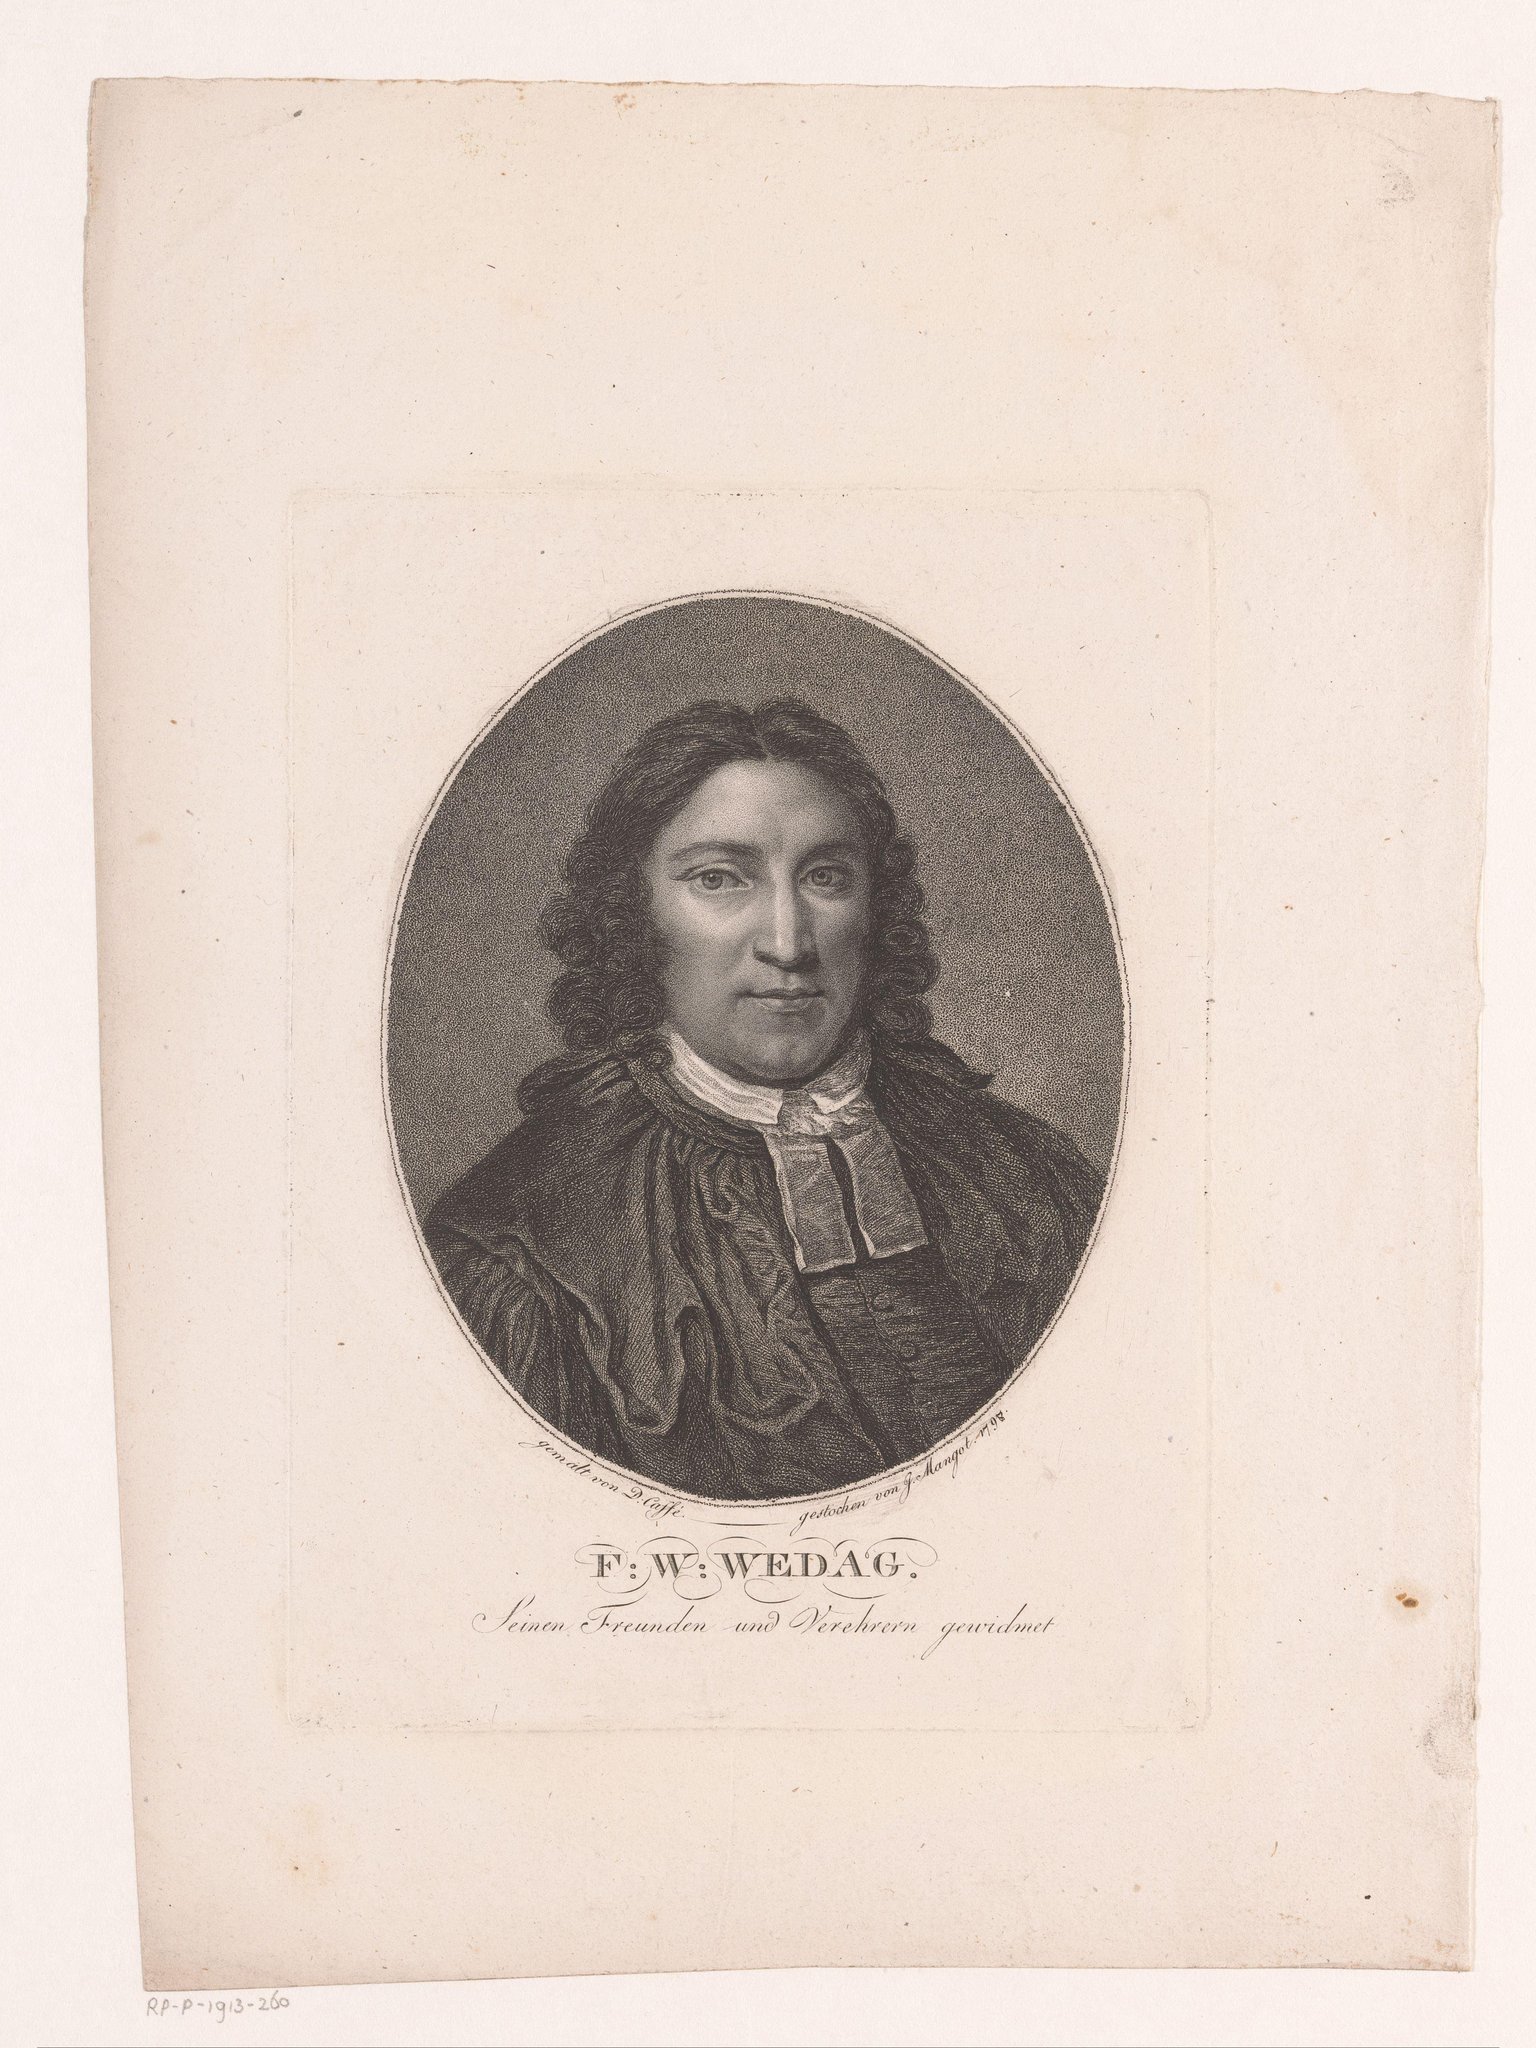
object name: print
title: Portret van Friedrich Wilhelm Wedag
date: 1798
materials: paper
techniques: engraving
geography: germany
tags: historical persons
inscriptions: collector's mark: Lugt 2228